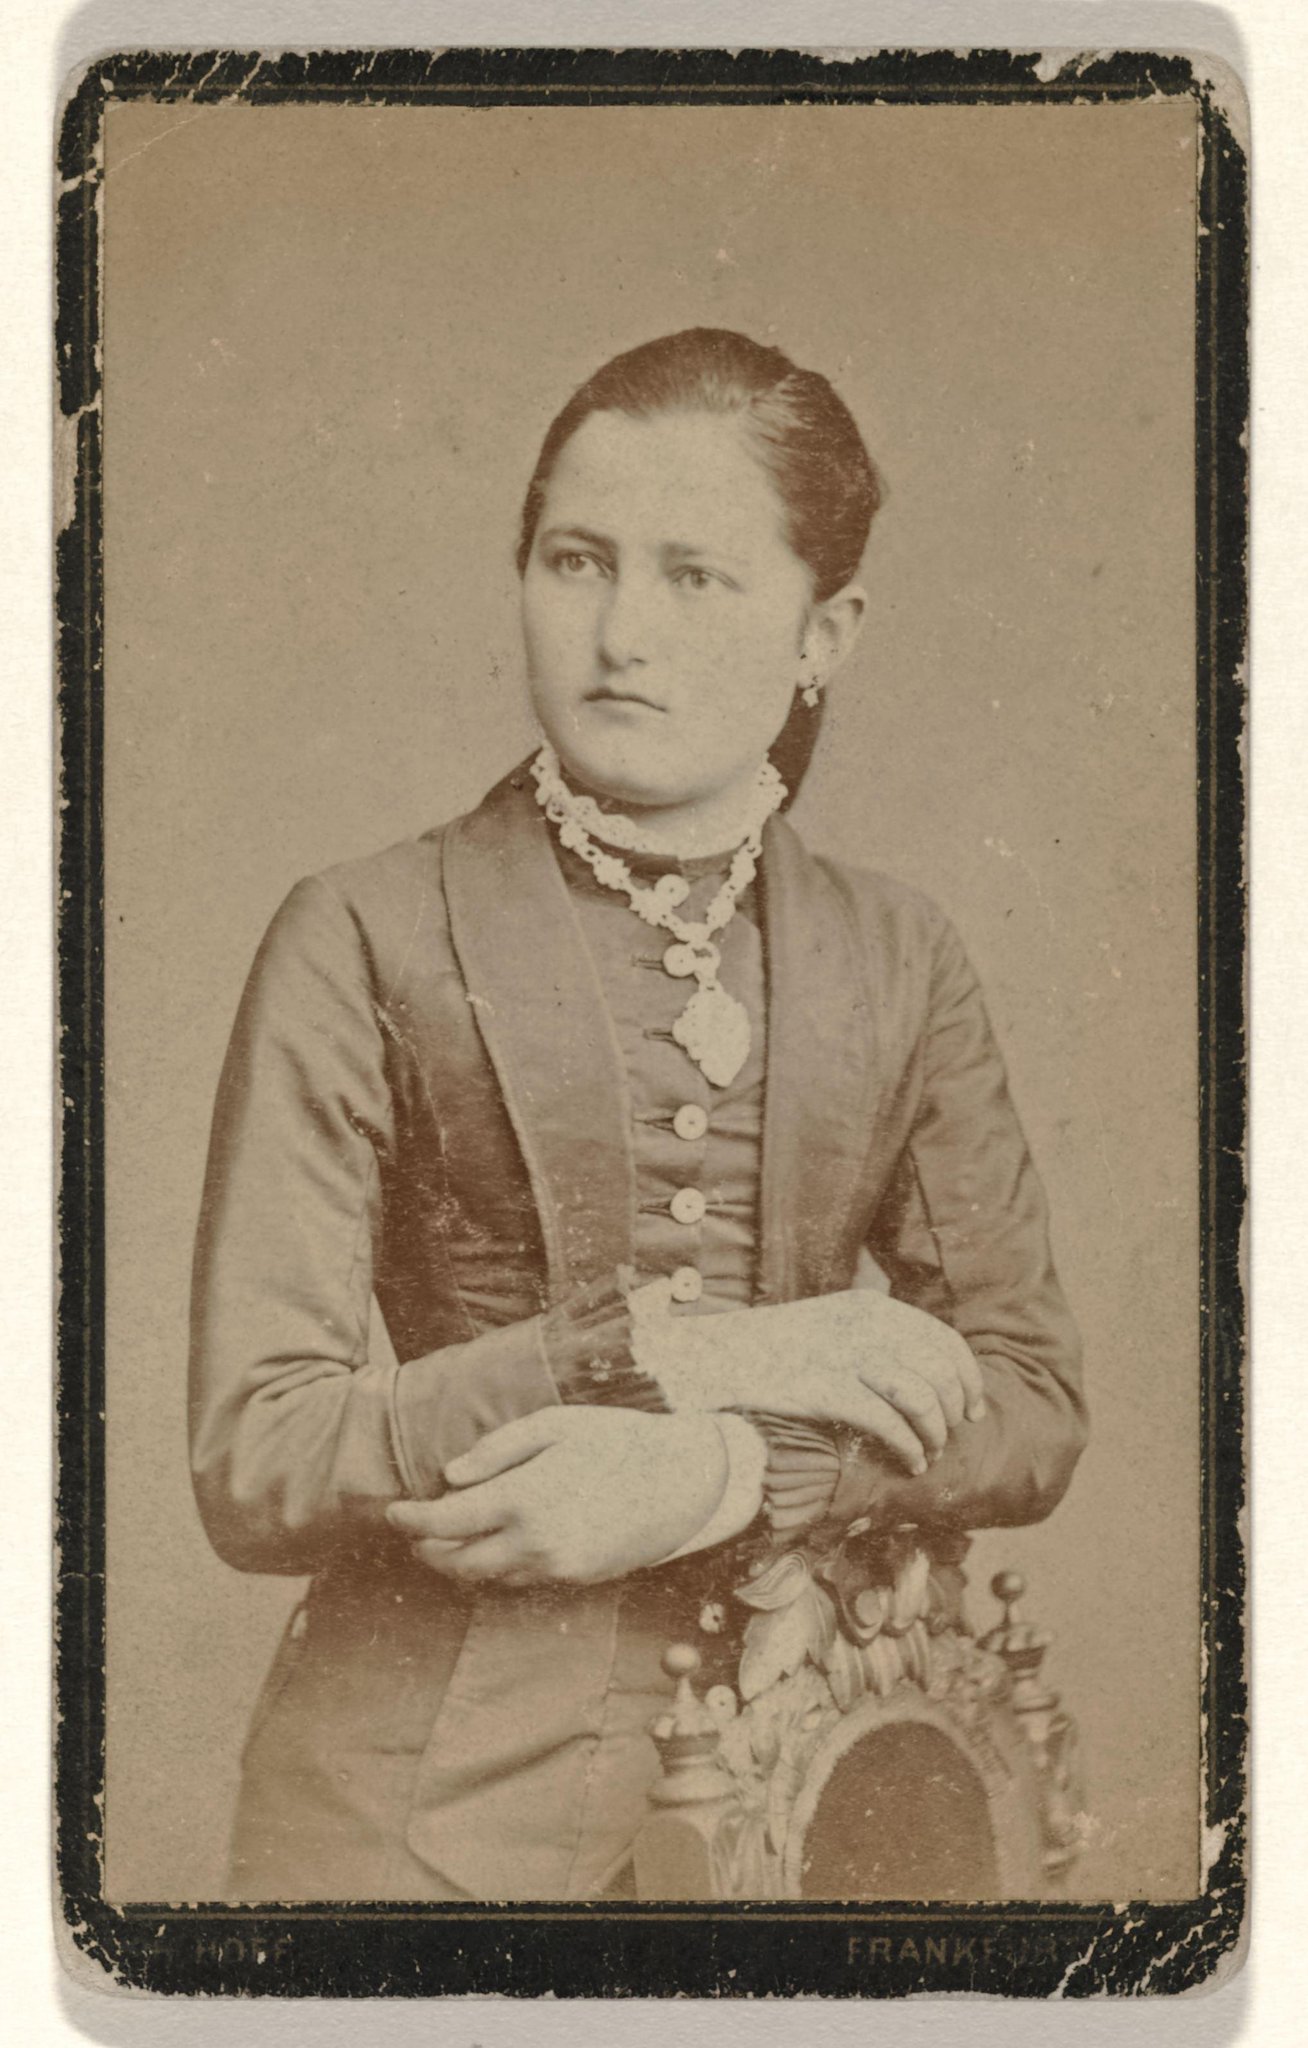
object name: photograph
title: Mathilde Wachenheimer-Wertheimer als jonge vrouw in een getailleerde jas met haar armen gevouwen boven een bewerkte stoel, met een ketting om haar nek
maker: Anonymous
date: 1885-1900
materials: photographic support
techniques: gelatin silver print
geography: frankfurt am main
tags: sobibór, mathilde wachenheimer-wertheimer, frankfurt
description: Mathilde Wachenheimer-Wertheimer als jonge vrouw in een getailleerde jas met haar armen gevouwen boven een bewerkte stoel, met een ketting om haar nek